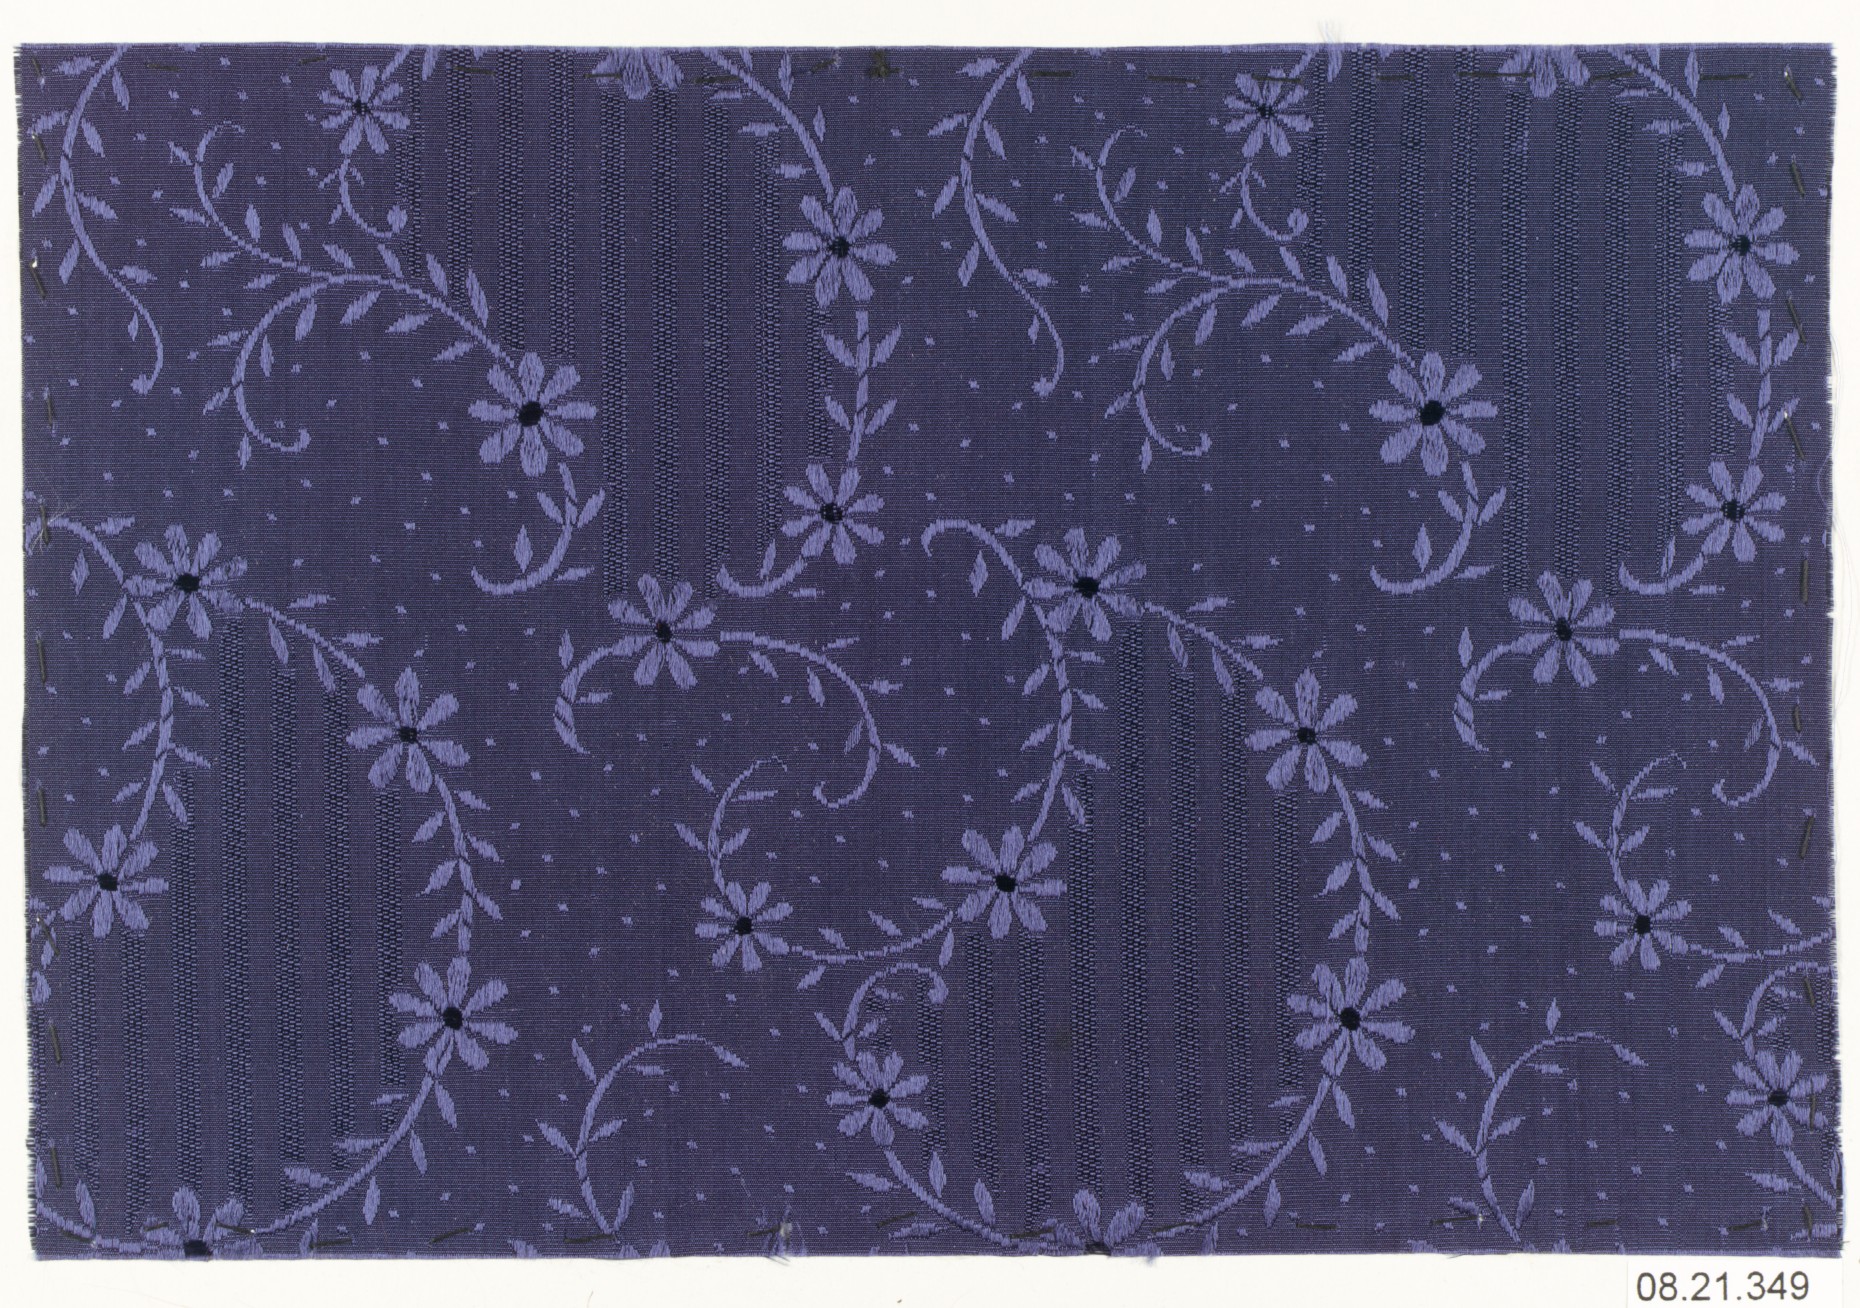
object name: textile sample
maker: Anonymous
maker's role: designer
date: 1900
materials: silk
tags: flowers